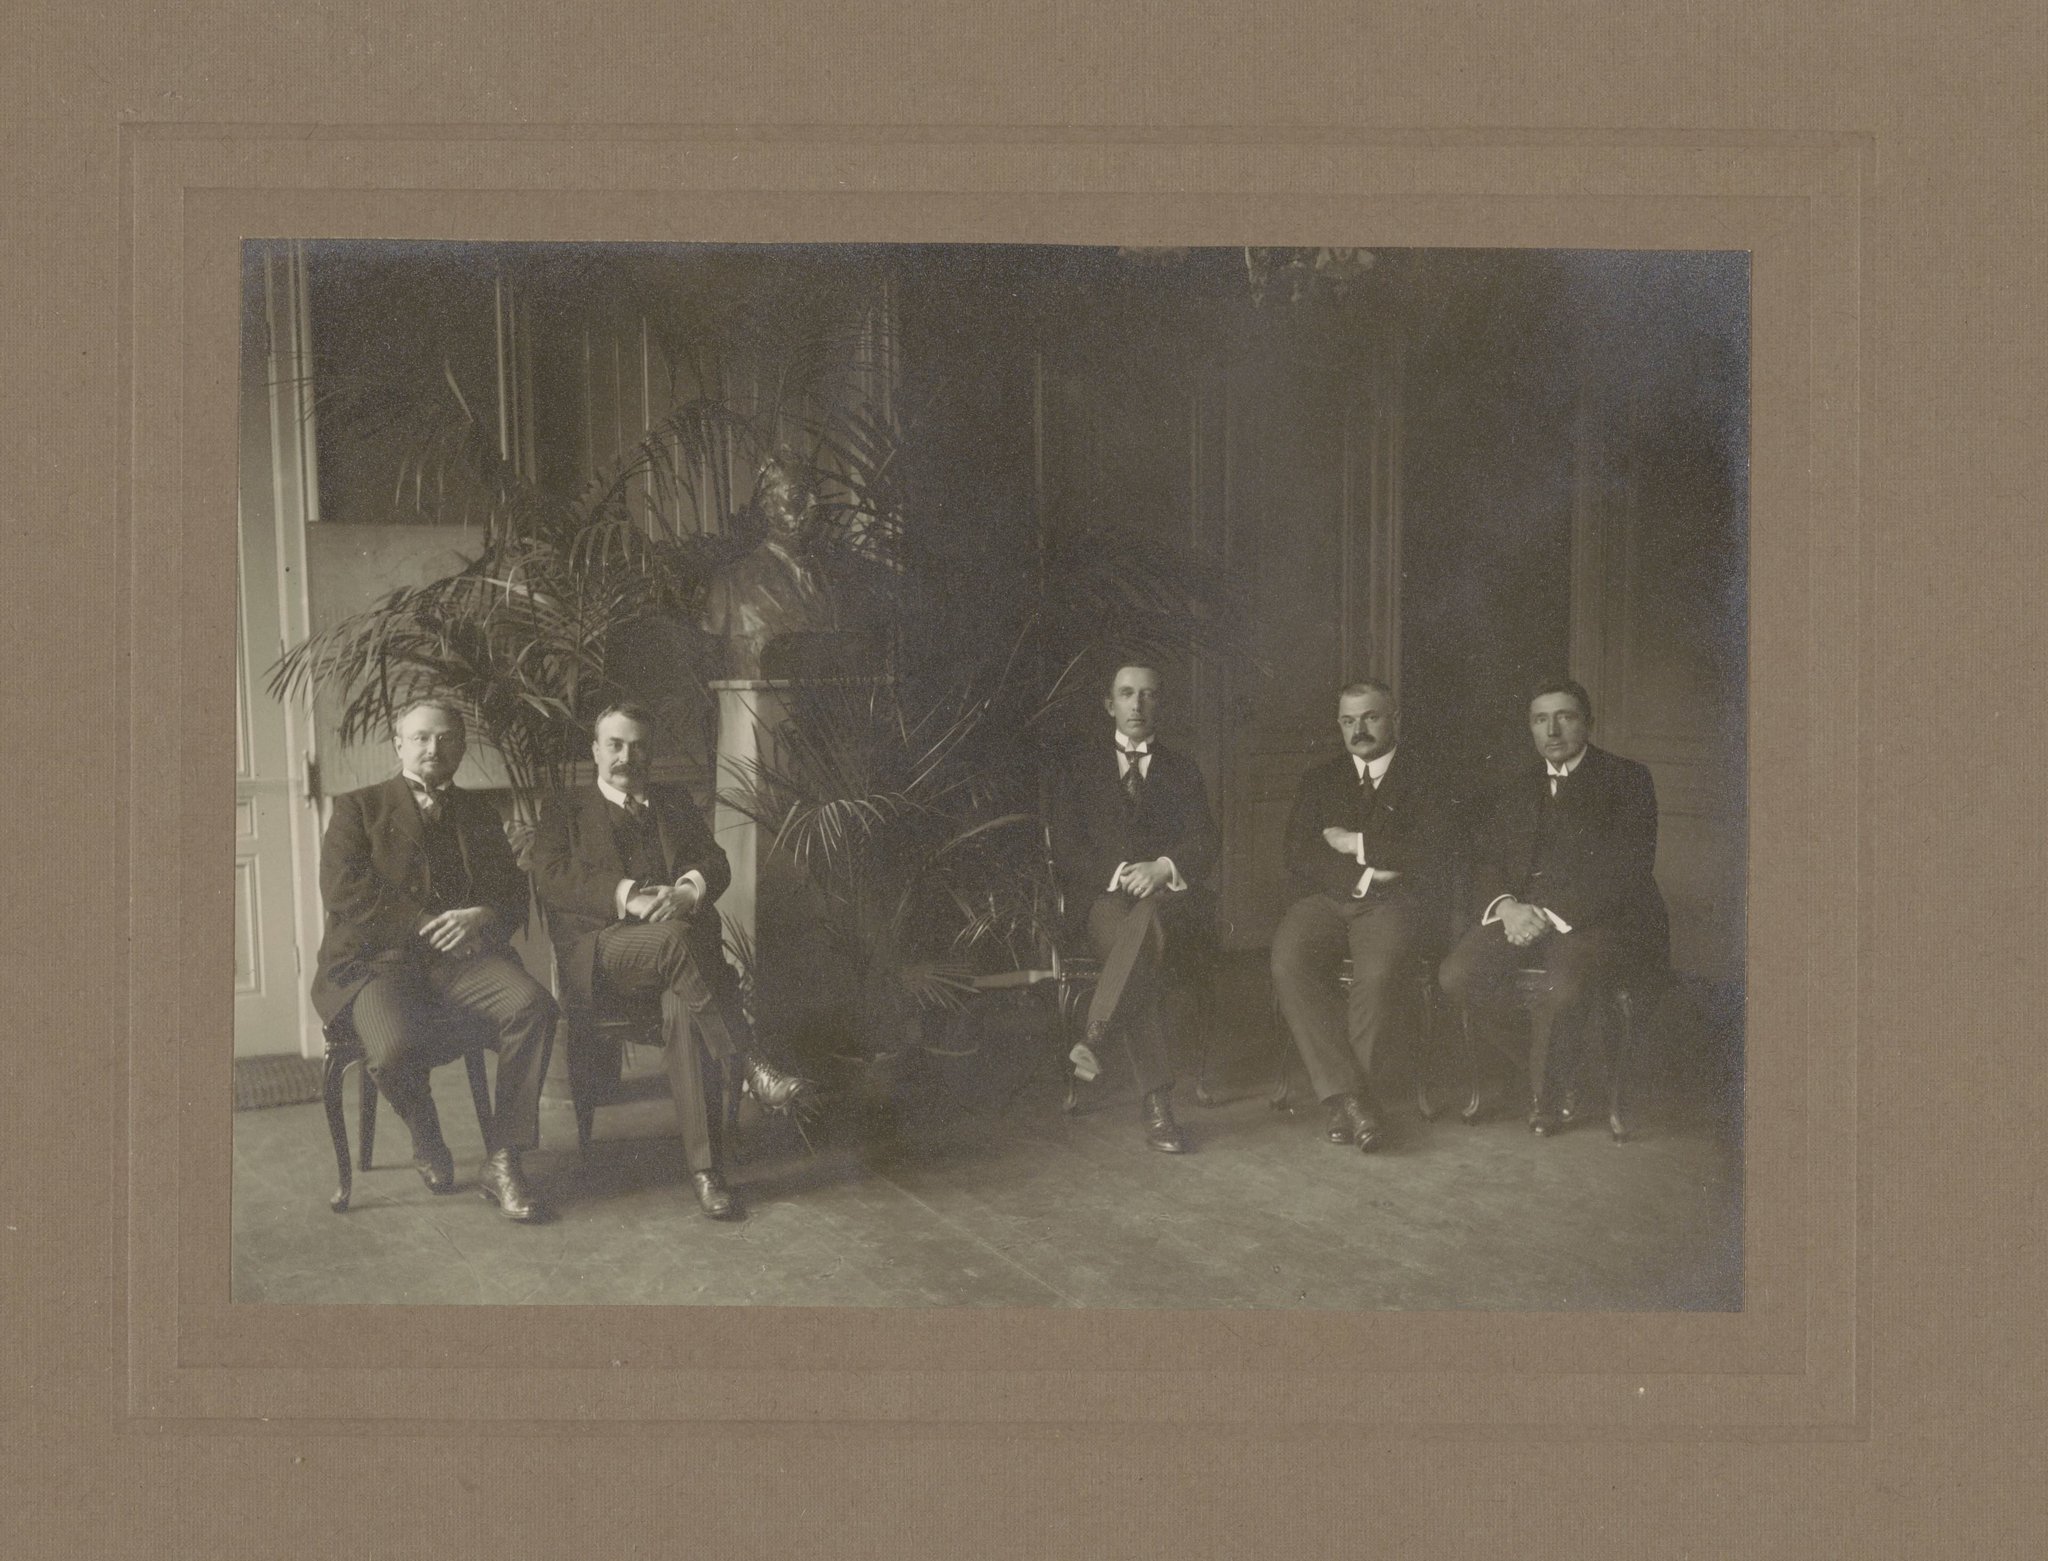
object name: photograph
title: Vijf heren rond een buste van Dr. Ruysch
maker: Anonymous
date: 1918-1944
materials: cardboard, photographic support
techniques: gelatin silver print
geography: netherlands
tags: amsterdam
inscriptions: annotation: ‘Overdracht der buste van // Dr. Ruysch aan het Veiligheidsmuseum // v.l. naar r. ir H.J. Scholte // Dr Josephus Jitta (Voorz:v/d Gezondheids // raad // Dr Ruysch (zoon van bovengenoemde // Dr Ruysch) // C.J.P.Zaalberg // - - - - - - -’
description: Wilhelm Pieter Ruysch was tot 1918 voorzitter van de gezondheidsraad; C.C.P. Zaalberg overleed in 1944.